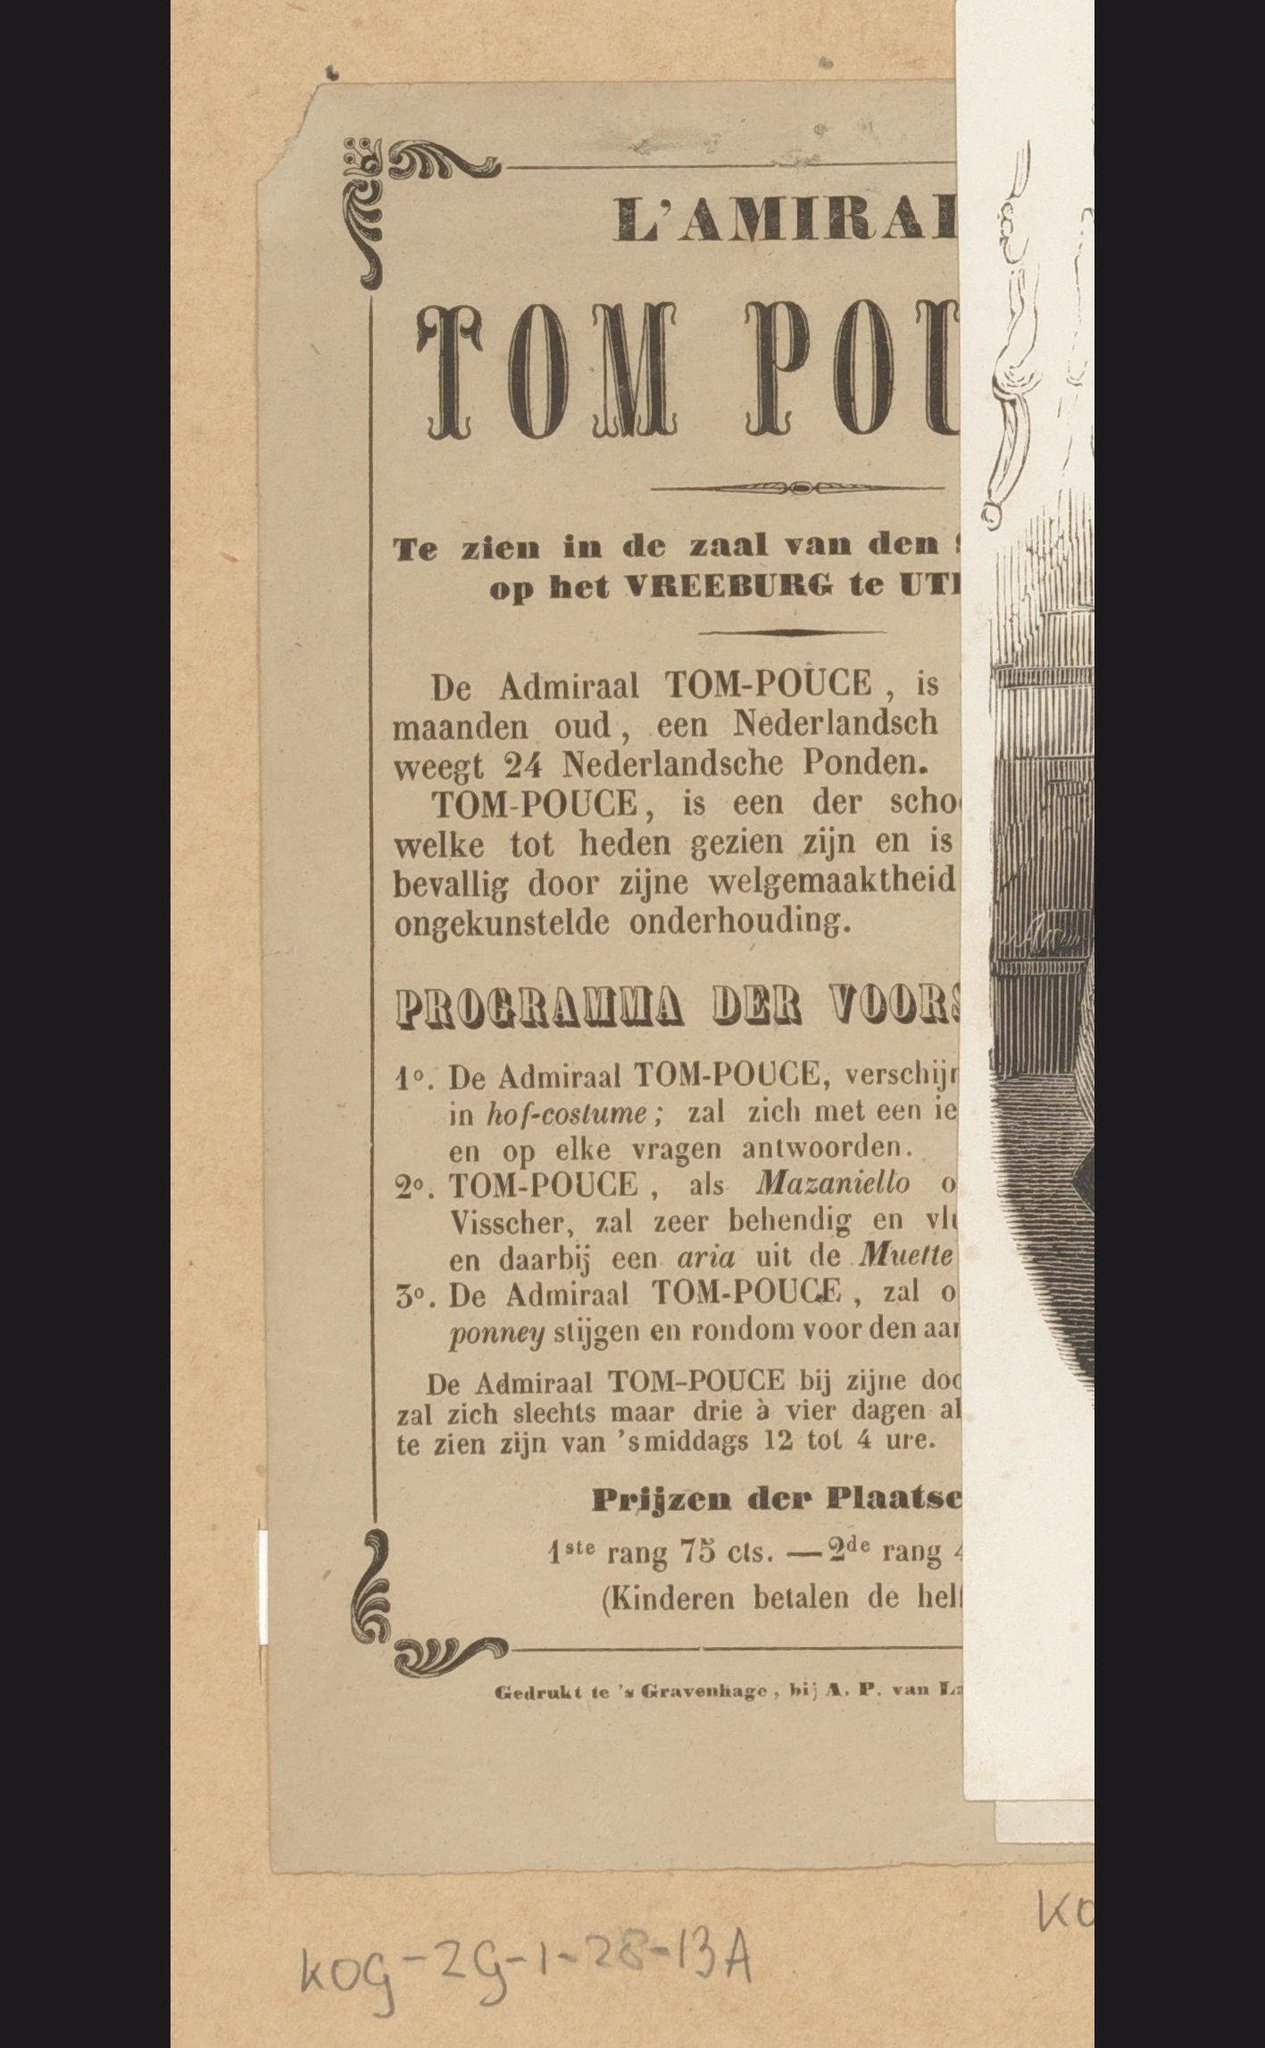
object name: text sheet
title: Strooibiljet met aankondiging van Jan Hannema, alias admiraal Tom Pouce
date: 1830-1846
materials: paper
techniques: letterpress printing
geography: the hague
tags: jan hannema, little people, portrait of actor, actress, historical persons (portraits and scenes from the life)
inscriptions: stamp, collector's mark: Lugt 1641, stamp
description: Onderwerpsrubrieken binnen de Atlas Zeden en Gewoonten: Zeden en Gewoonten in Engeren Zin. Volksleven. Volksfeesten. Kermistypen, wondermenschen en dergelijken.